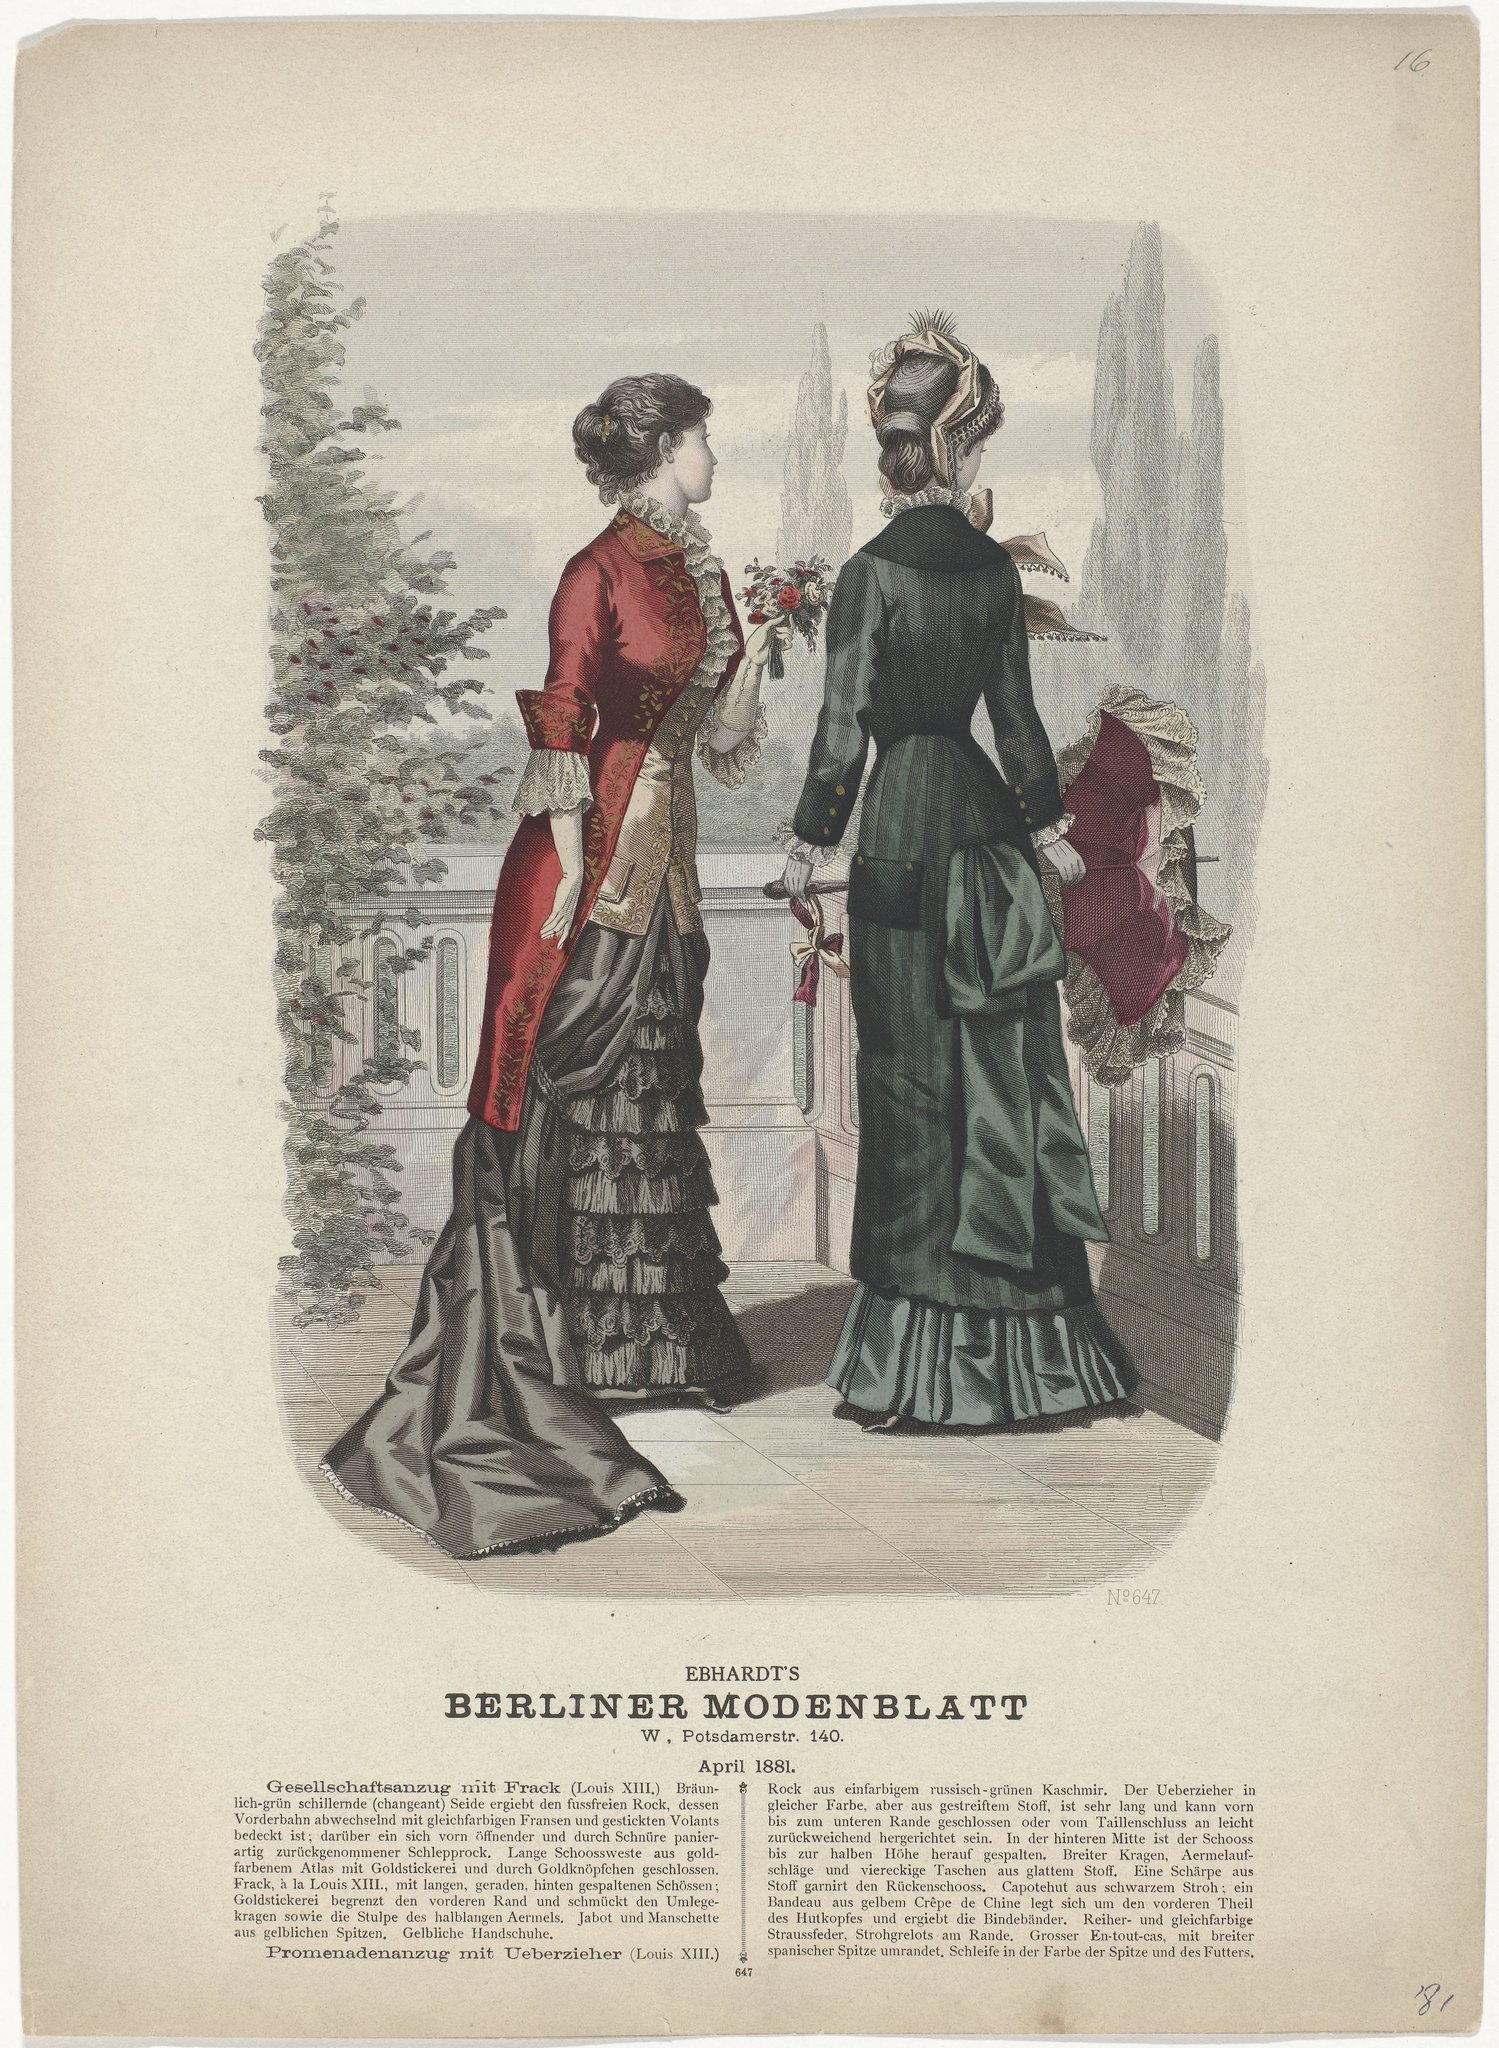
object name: fashion print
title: An Explosion of Fashion Magazines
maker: Anonymous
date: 1881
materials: paper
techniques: engraving, hand coloring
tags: cut flowers; nosegay, bunch of flowers, head-gear (capote) (+ women's clothes), gloves, mittens (long gloves) (+ women's clothes), dress, gown: walking dress (+ women's clothes), fashion plates, skirt (+ women's clothes), parasol, sunshade (+ women's clothes)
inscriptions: caption: ‘Gesellschafsanzug mit Frack (Louis XIII.) Bräun-lich-grün schillernde (changeant) Seide ergiebt den fussfreien Rock, dessen Vorderbahn abwechselnd mit gleichfarbigen Fransen und gestickten Volants bedeckt ist; darüber ein sich vorn öffnender und durch Schnüre panier-artig zurückgenommener Schlepprock. lange Schoossweste aus goldfarbenem Atlas mit Goldstickerei und durch Goldknöpfchen geschlossen. ...... Capotehut aus schwarzem Stroh; ein Bandeau aus gelbem Crêpe de Chine legt sich um des vorderen theil des Hutkopfes und ergiebt die Bindebänder.’, title: ‘EBHARDT'S / BERLINER MODENBLATT’, address: ‘W., Potsdamerstr. 140. / April 1881’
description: Starting from the 1850s, fashion magazines became more affordable and acquired a wider readership. The invention of the sewing machine around 1850 made it easier for people to make their own clothes. Ready-made garments were now also on offer, with fashion plates providing vendor addresses, such as the Maison Gagelin in Paris.